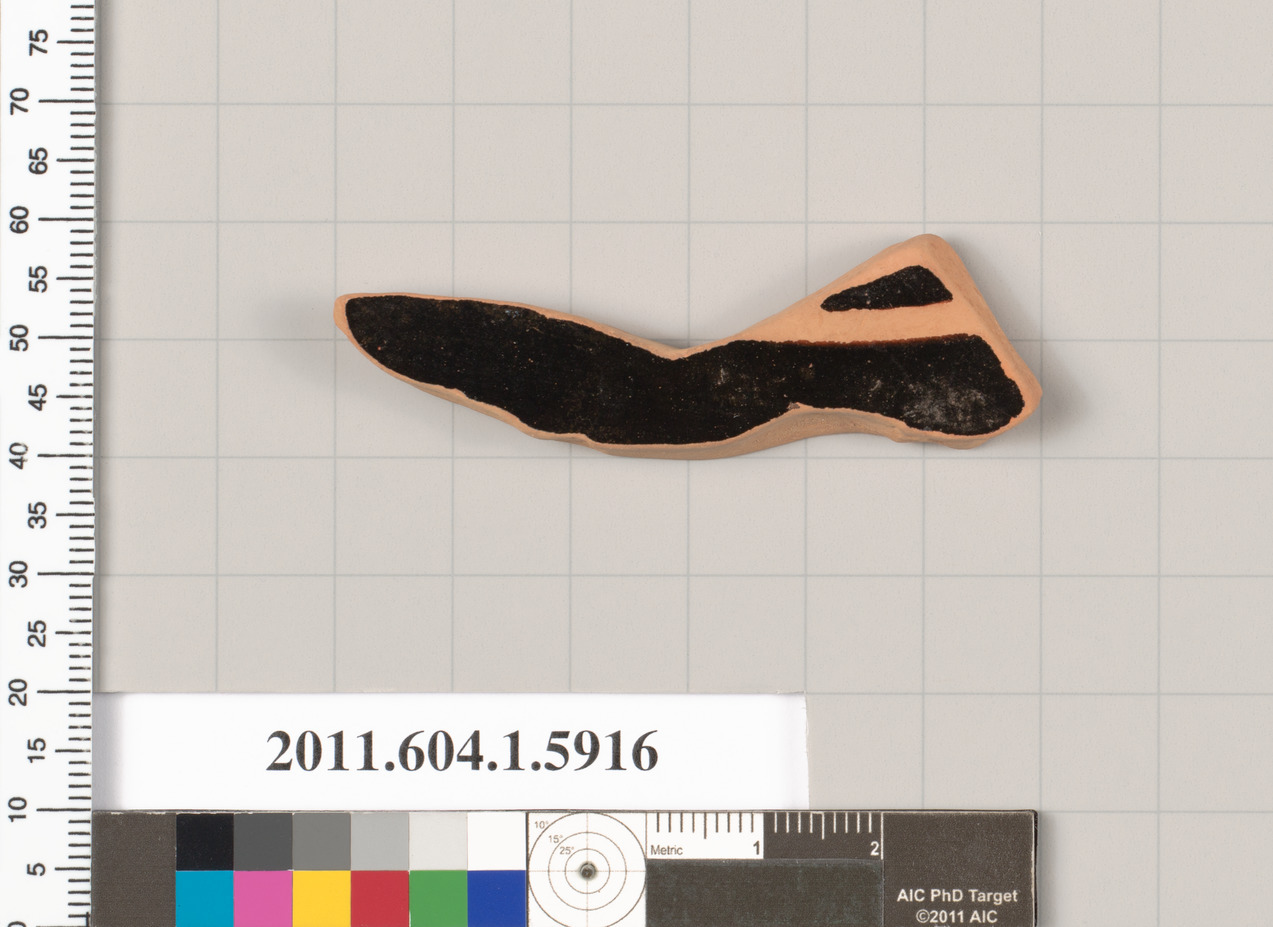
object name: kylix fragment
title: Terracotta fragment of a kylix (drinking cup)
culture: greek, attic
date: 520-510 BCE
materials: terracotta